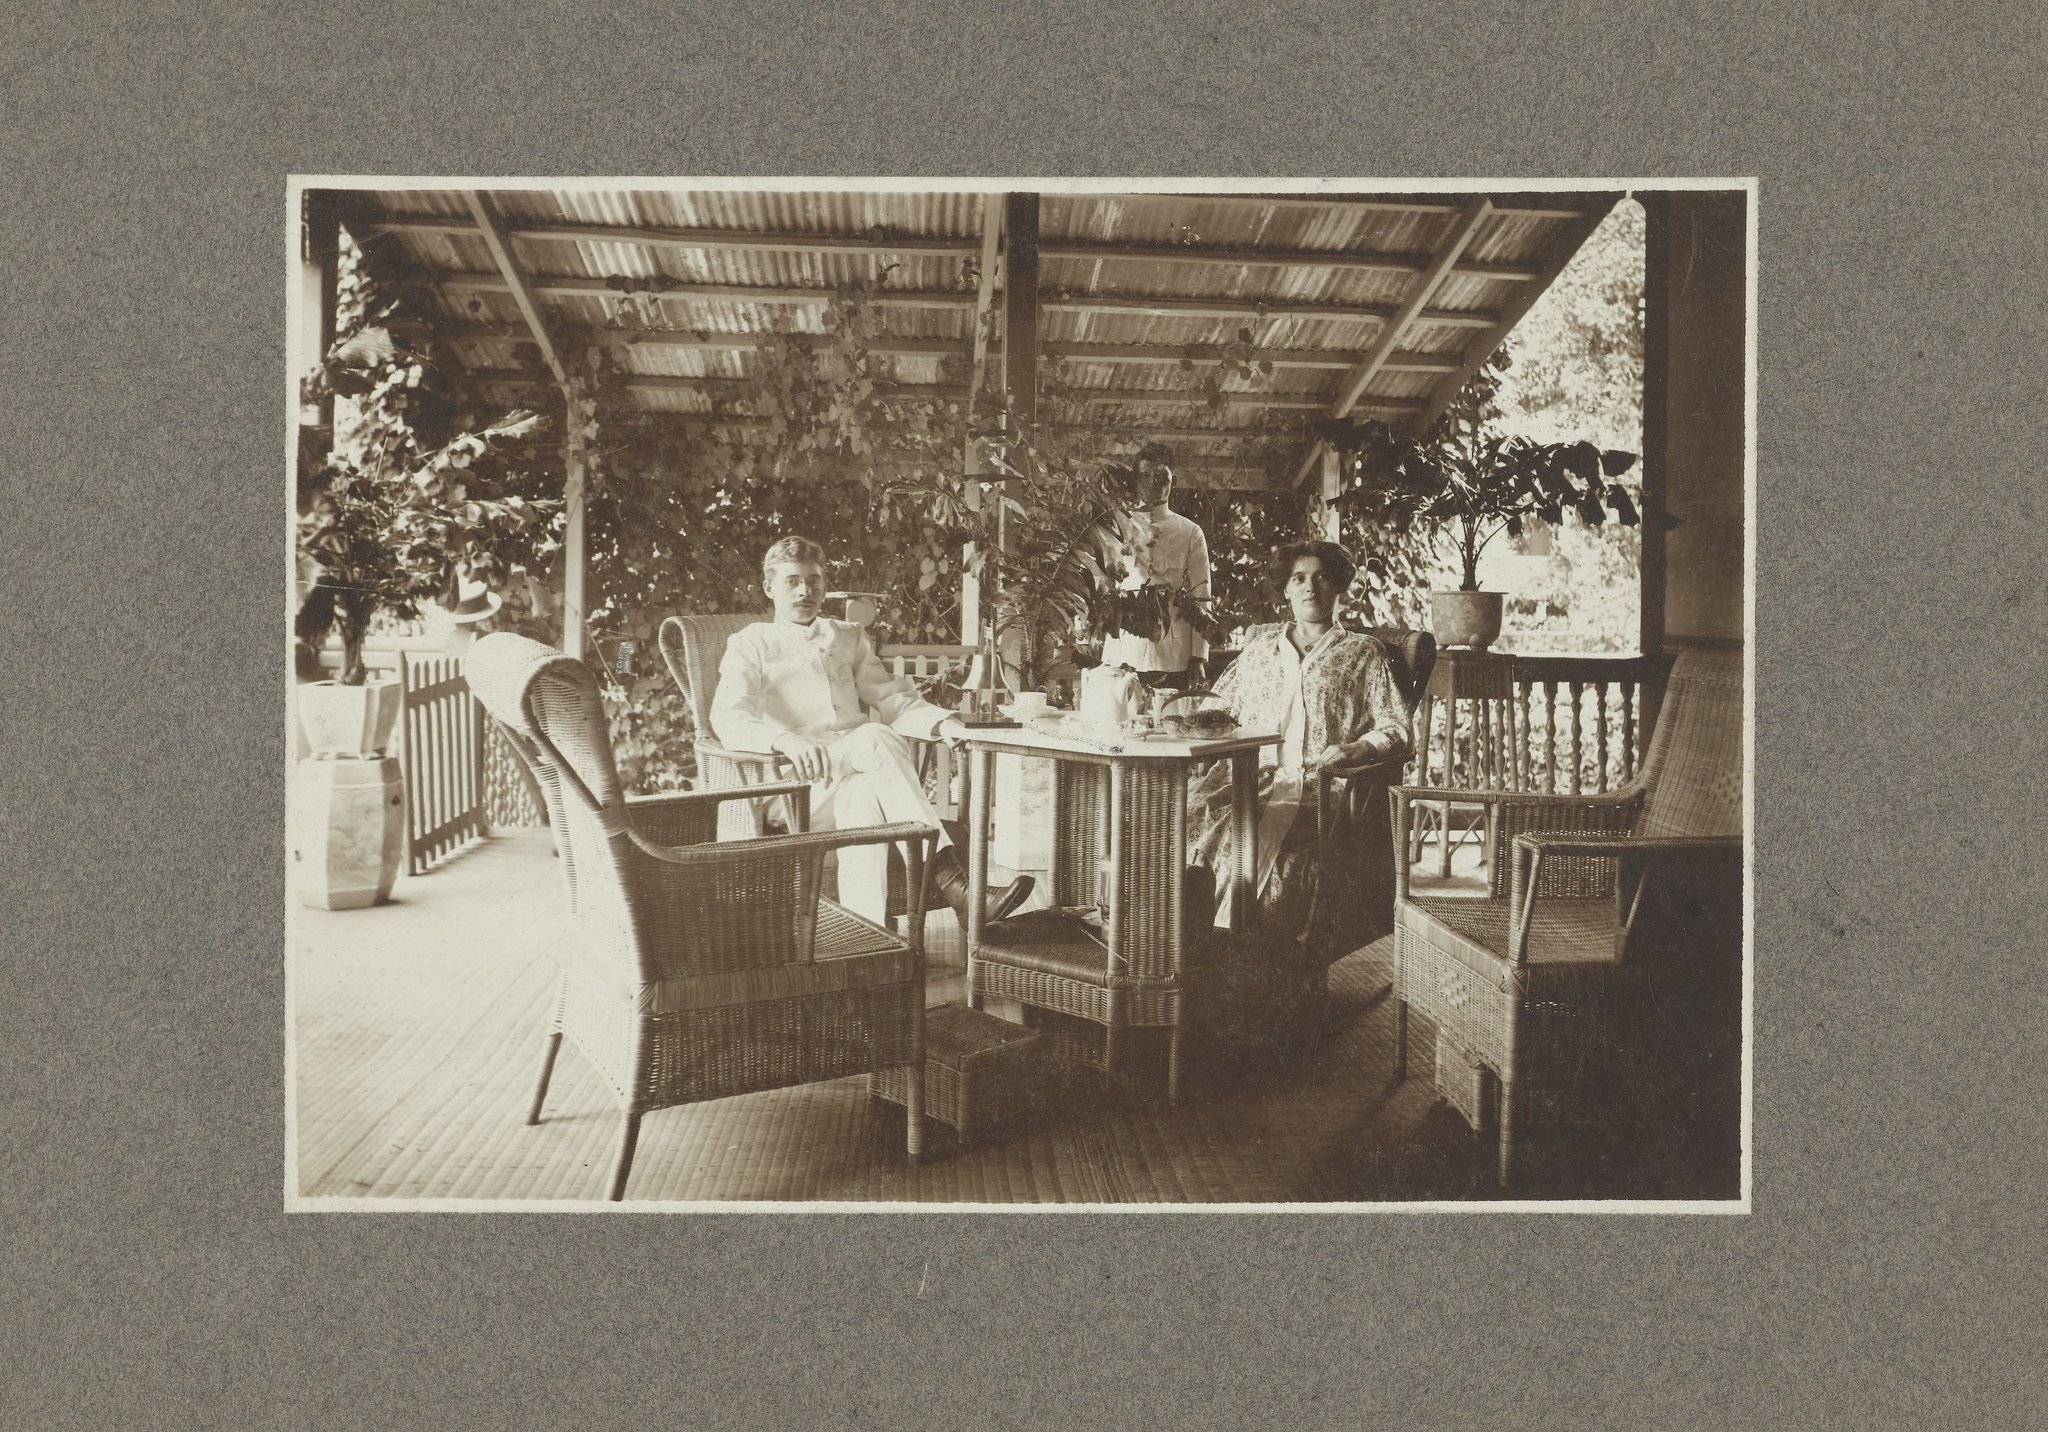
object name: photograph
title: Portret van een onbekend echtpaar en een bediende op een veranda in Nederlands-Indië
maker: Anonymous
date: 1890-1920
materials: paper, cardboard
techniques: gelatin silver print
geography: dutch east indies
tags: anonymous historical person portrayed, loggia, verandah, porch, house personnel, servants, dutch east indies, the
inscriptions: inscription: ‘Joo’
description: Zie gerelateerde objecten voor andere foto's van hetzelfde echtpaar.